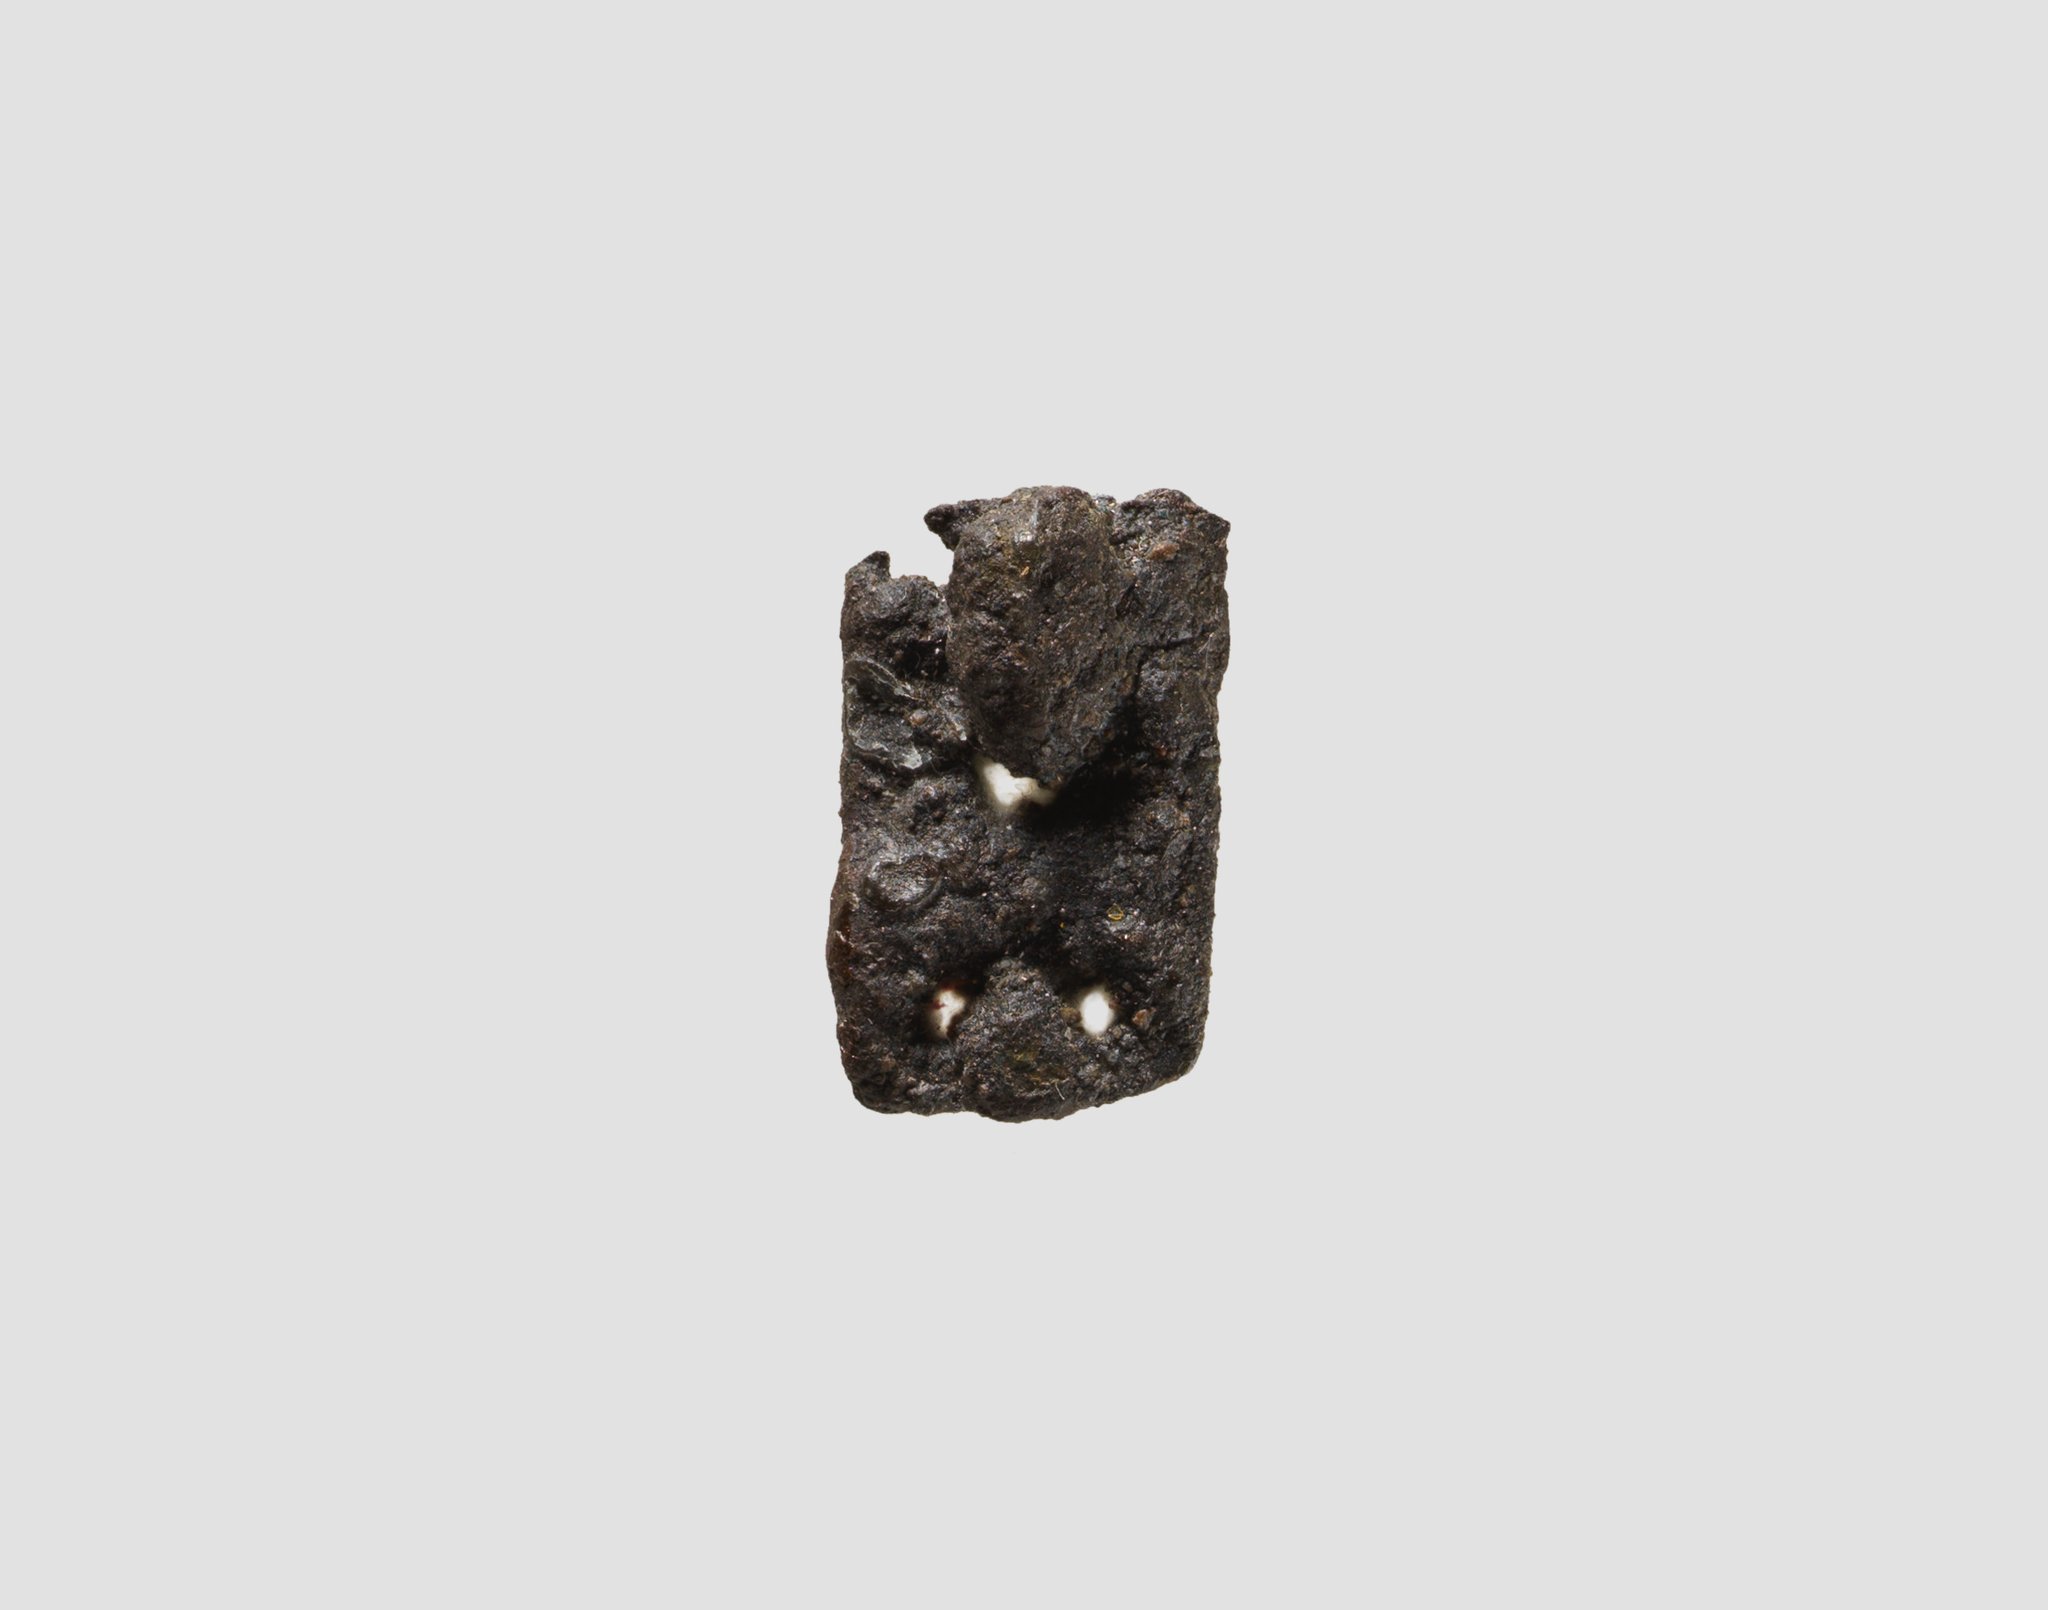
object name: armor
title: Armor plate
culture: assyrian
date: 734-601 BCE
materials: bronze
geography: mesopotamia